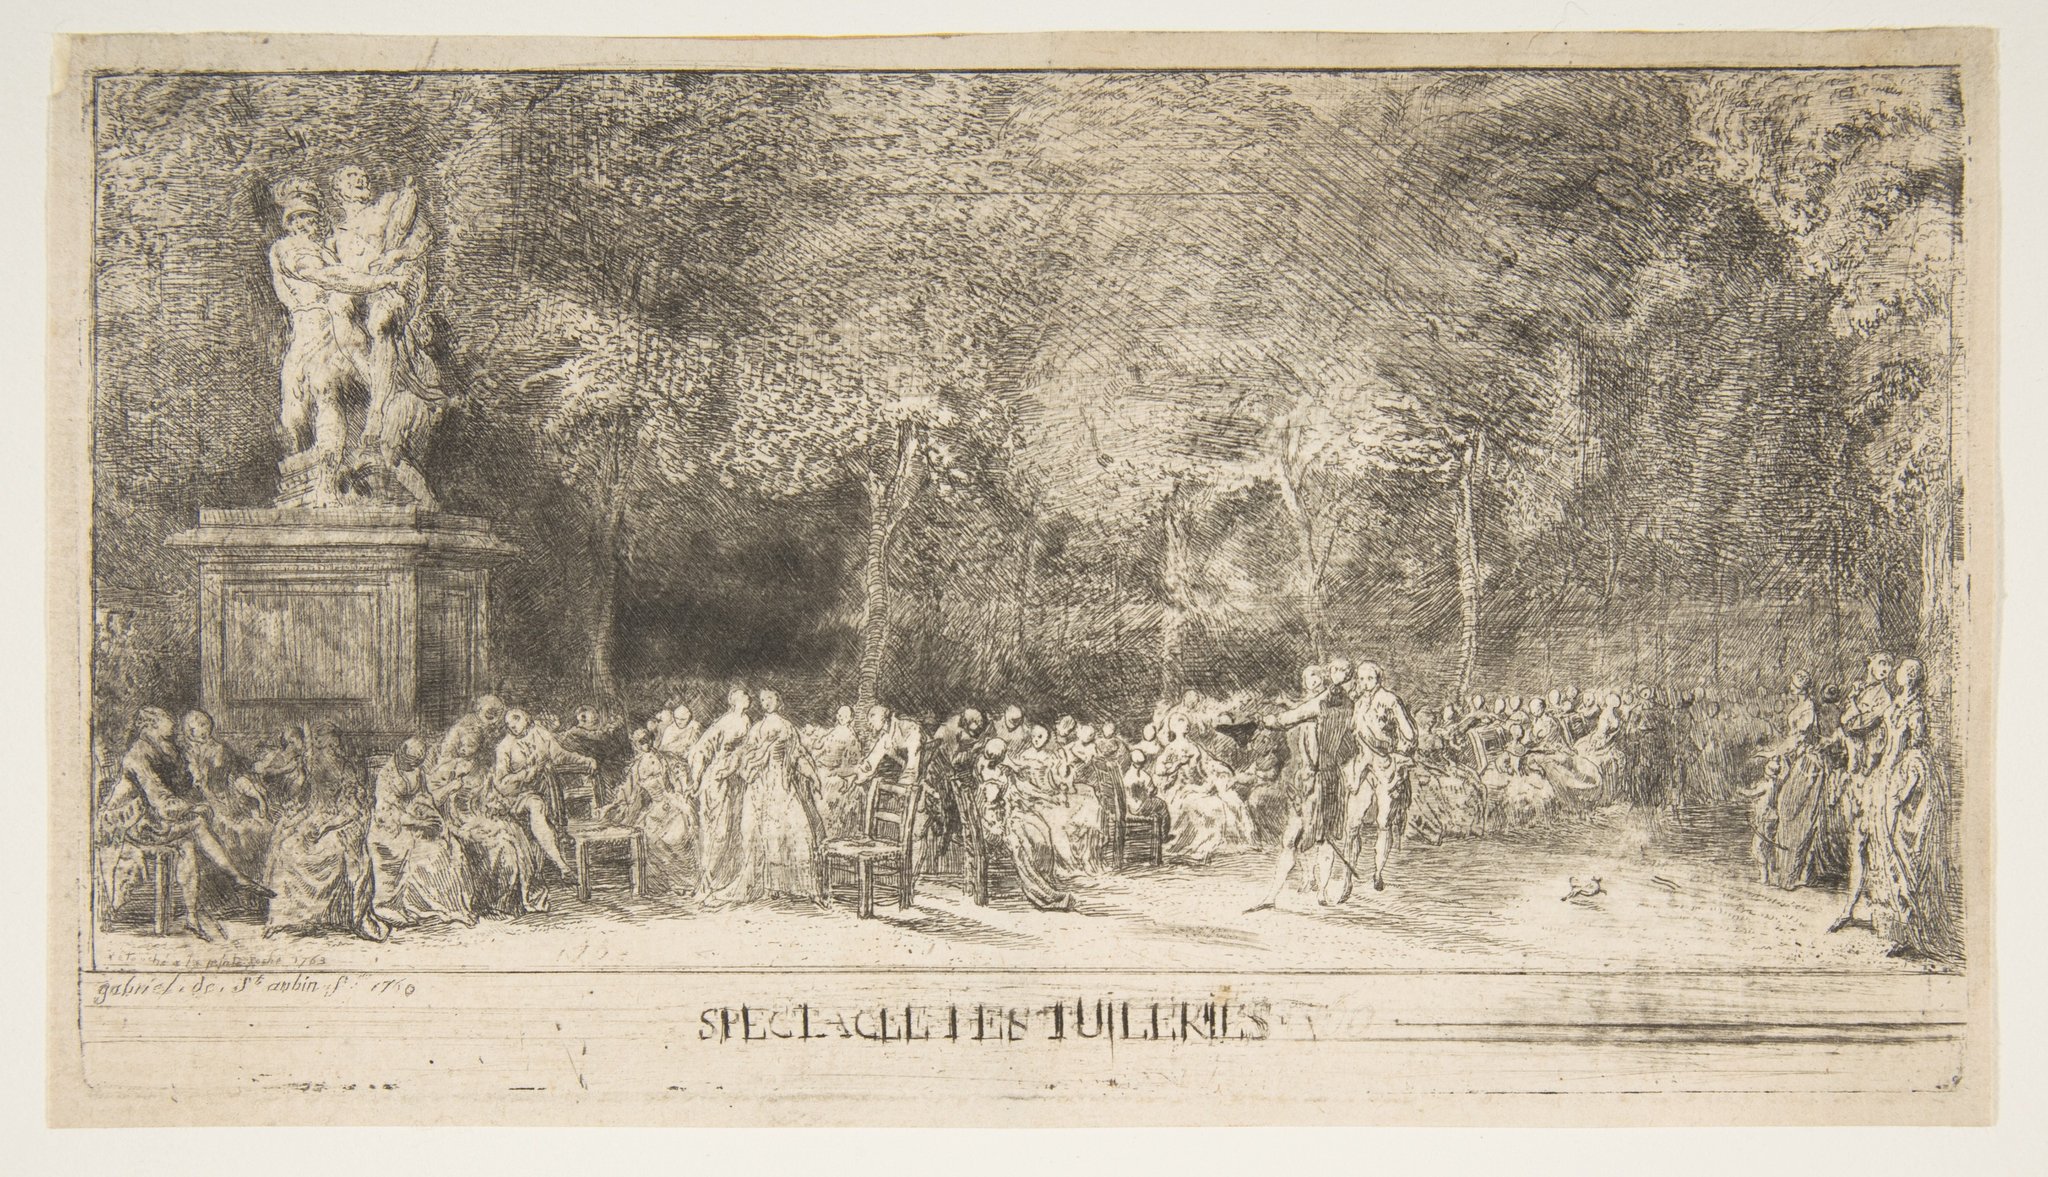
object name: print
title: Scene in the Tuileries: The Chairs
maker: gabriel de saint-aubin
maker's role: artist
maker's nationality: french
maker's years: 1724-1780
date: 1760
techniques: etching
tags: sculpture,men,women,trees,chairs